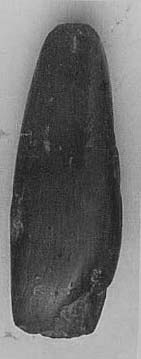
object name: chisel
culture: french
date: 1902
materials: jade